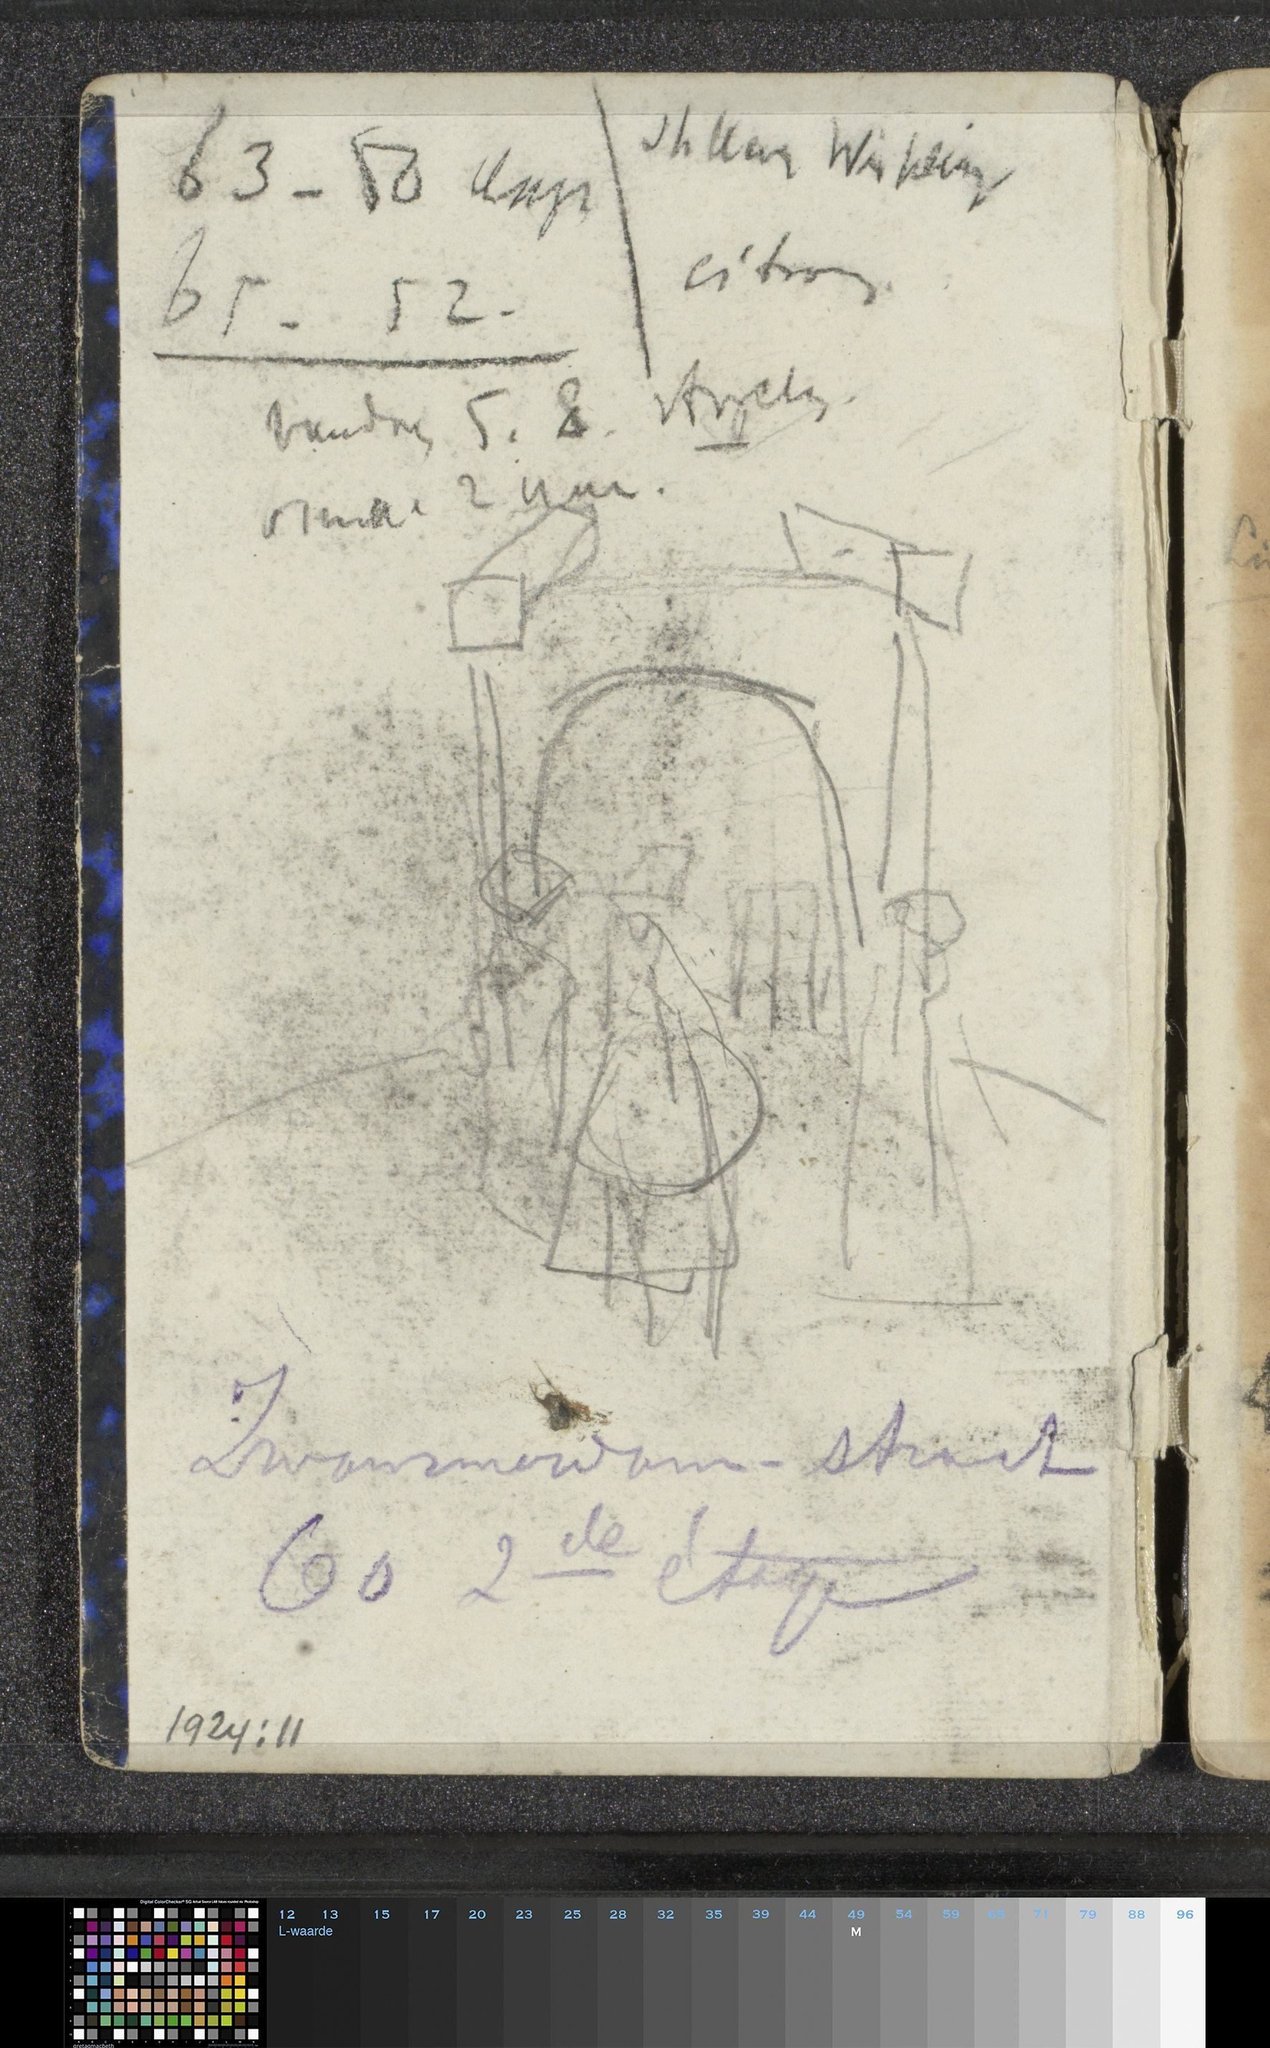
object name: sketchbook leaf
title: Figuren voor een brug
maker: george hendrik breitner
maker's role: draughtsman, painter, print maker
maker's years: 1857-1923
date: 1867-1923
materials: paper, pencil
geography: amsterdam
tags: adult woman, bridge in city across river, canal, etc., amsterdam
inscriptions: annotation: ‘[...]/ Zwammerdam-straat [sic]/ 60 2de etage’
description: Pagina 1, voorste schutblad, uit een schetsboek met 10 bladen.